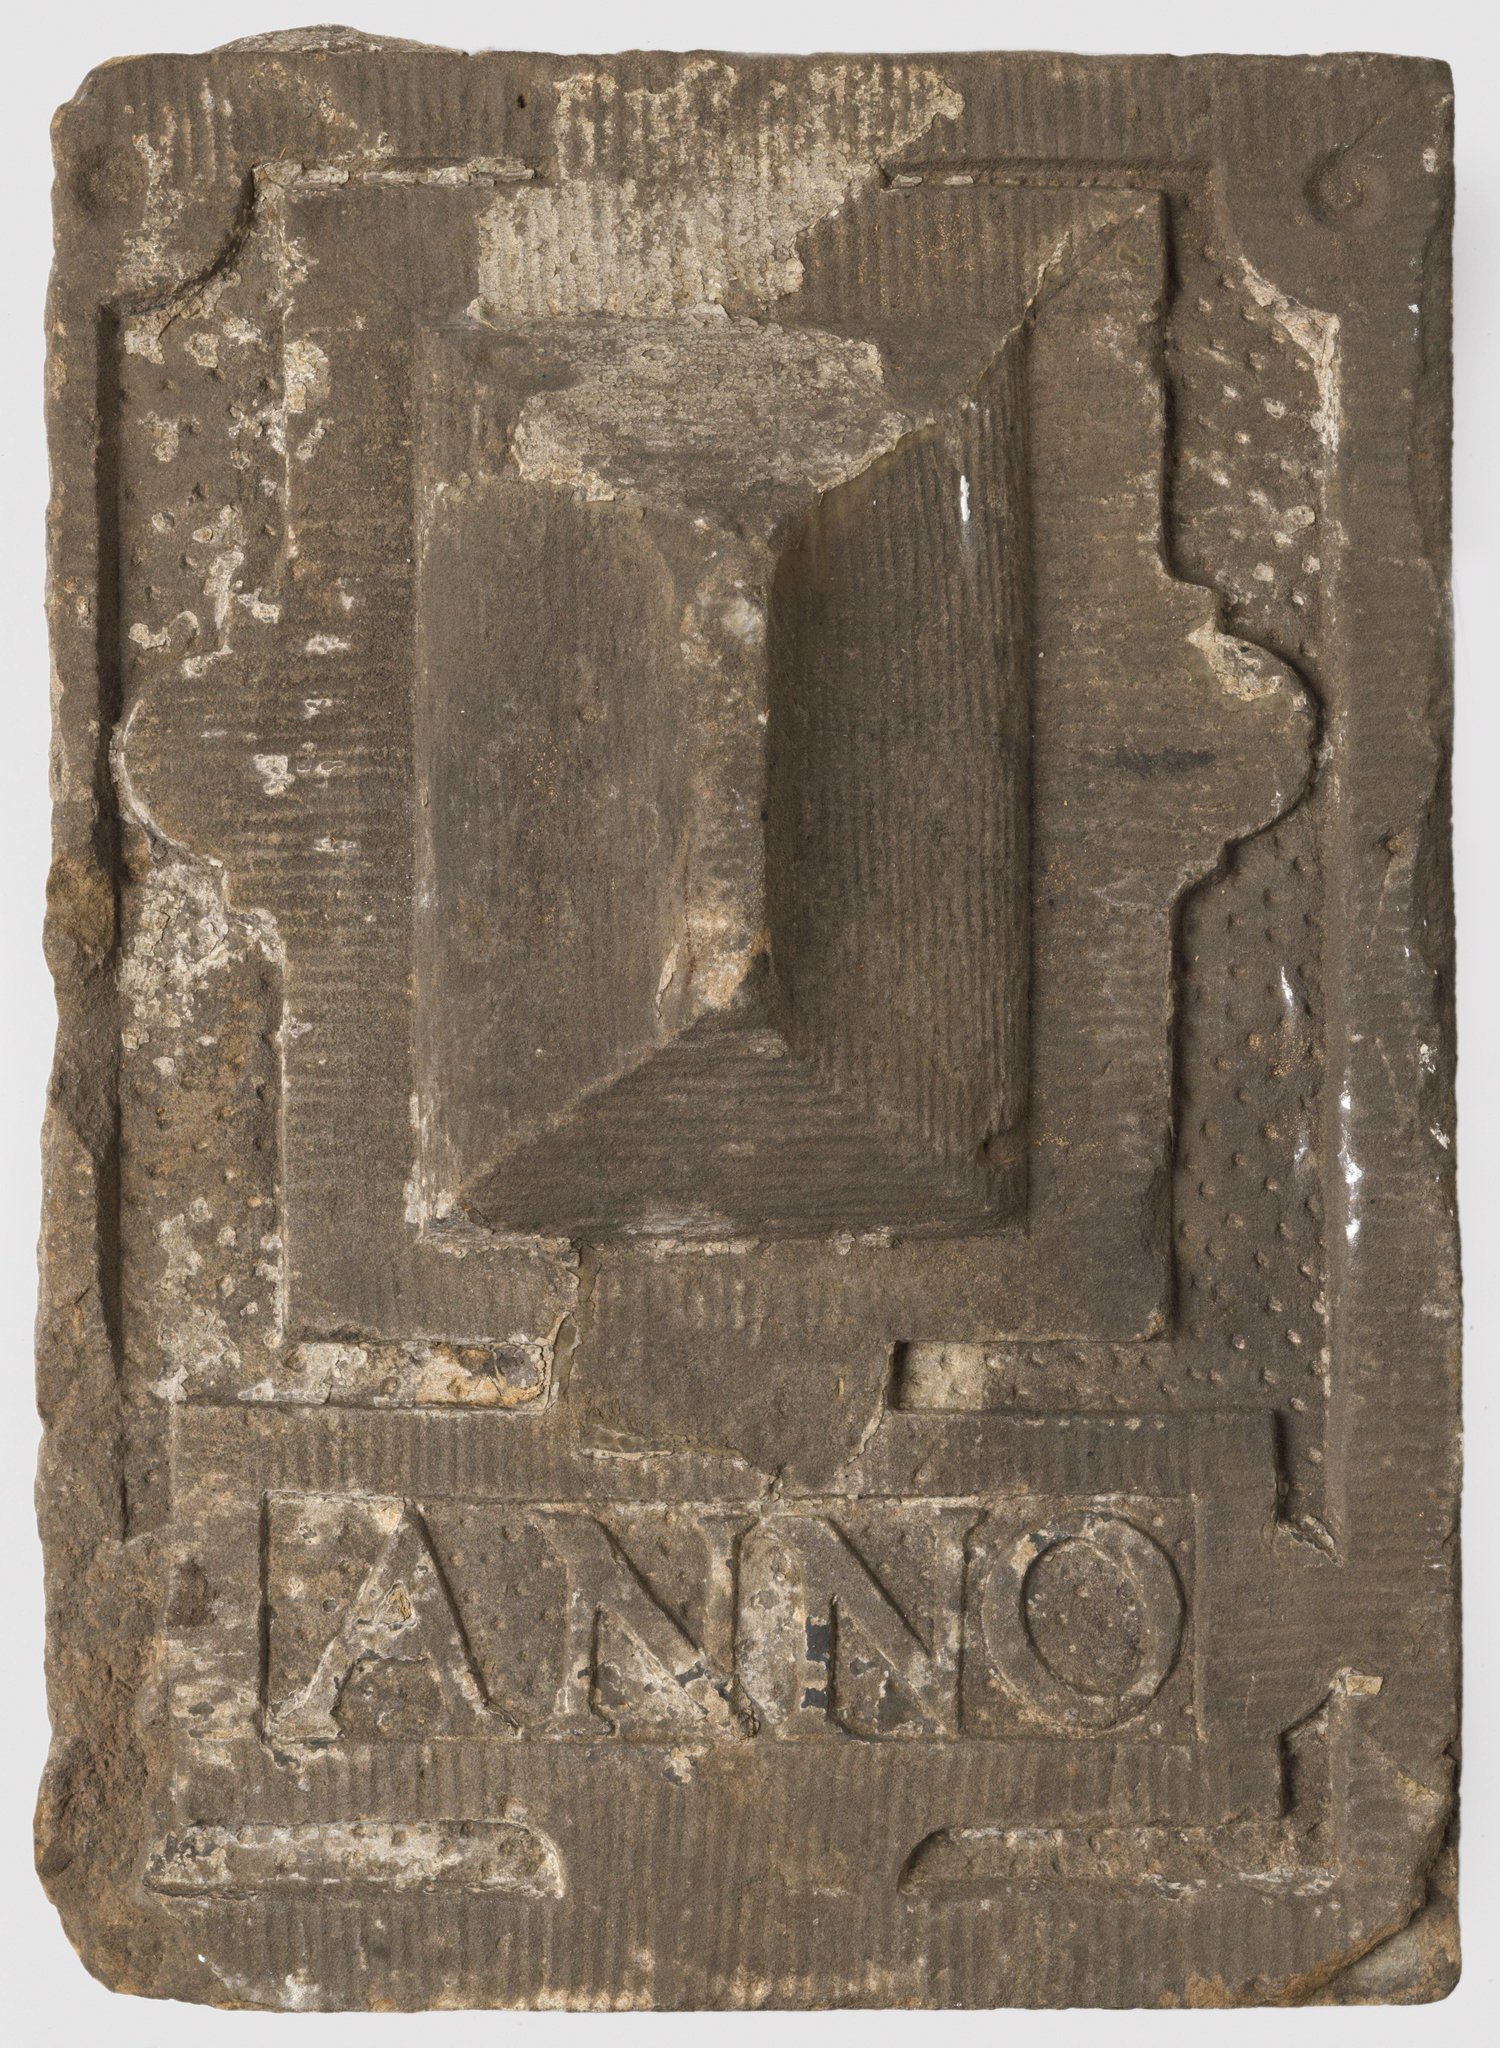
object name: gable stone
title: Gevelsteen met afbeelding en opschrift: ANNO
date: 1400-1950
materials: stone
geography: netherlands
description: Staande rechthoek waarbinnen een cartouche met boven een staande rechthoekige vorm (stempel of kussen?) en daaronder het opschrift ANNO.